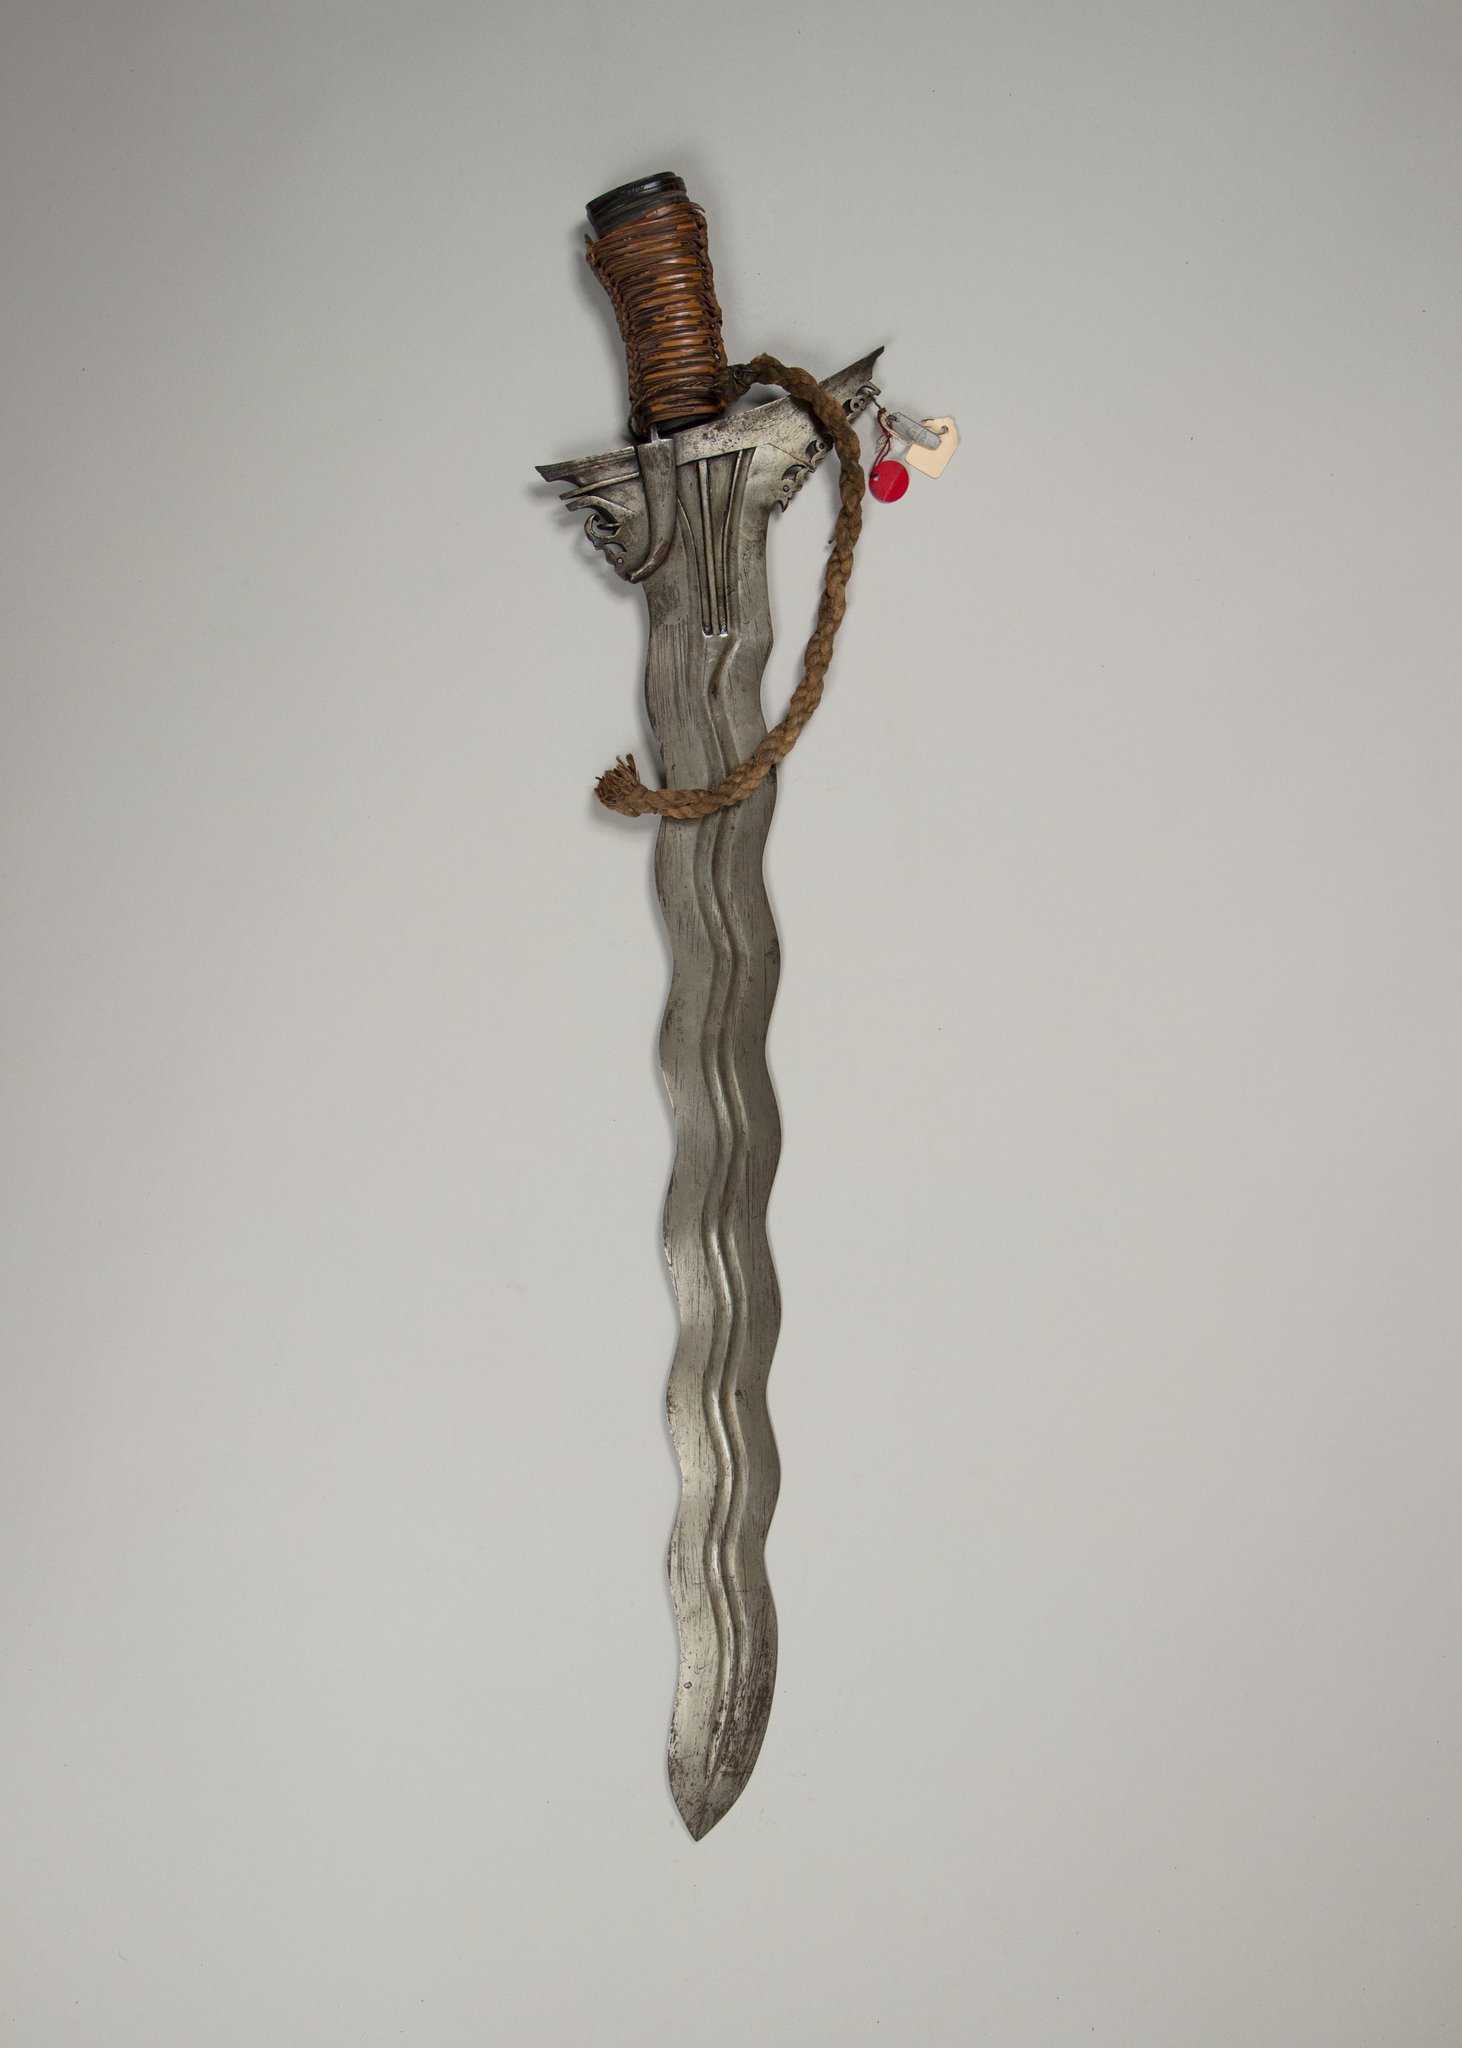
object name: kris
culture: philippine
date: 1701-1900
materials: horn, steel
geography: philippines